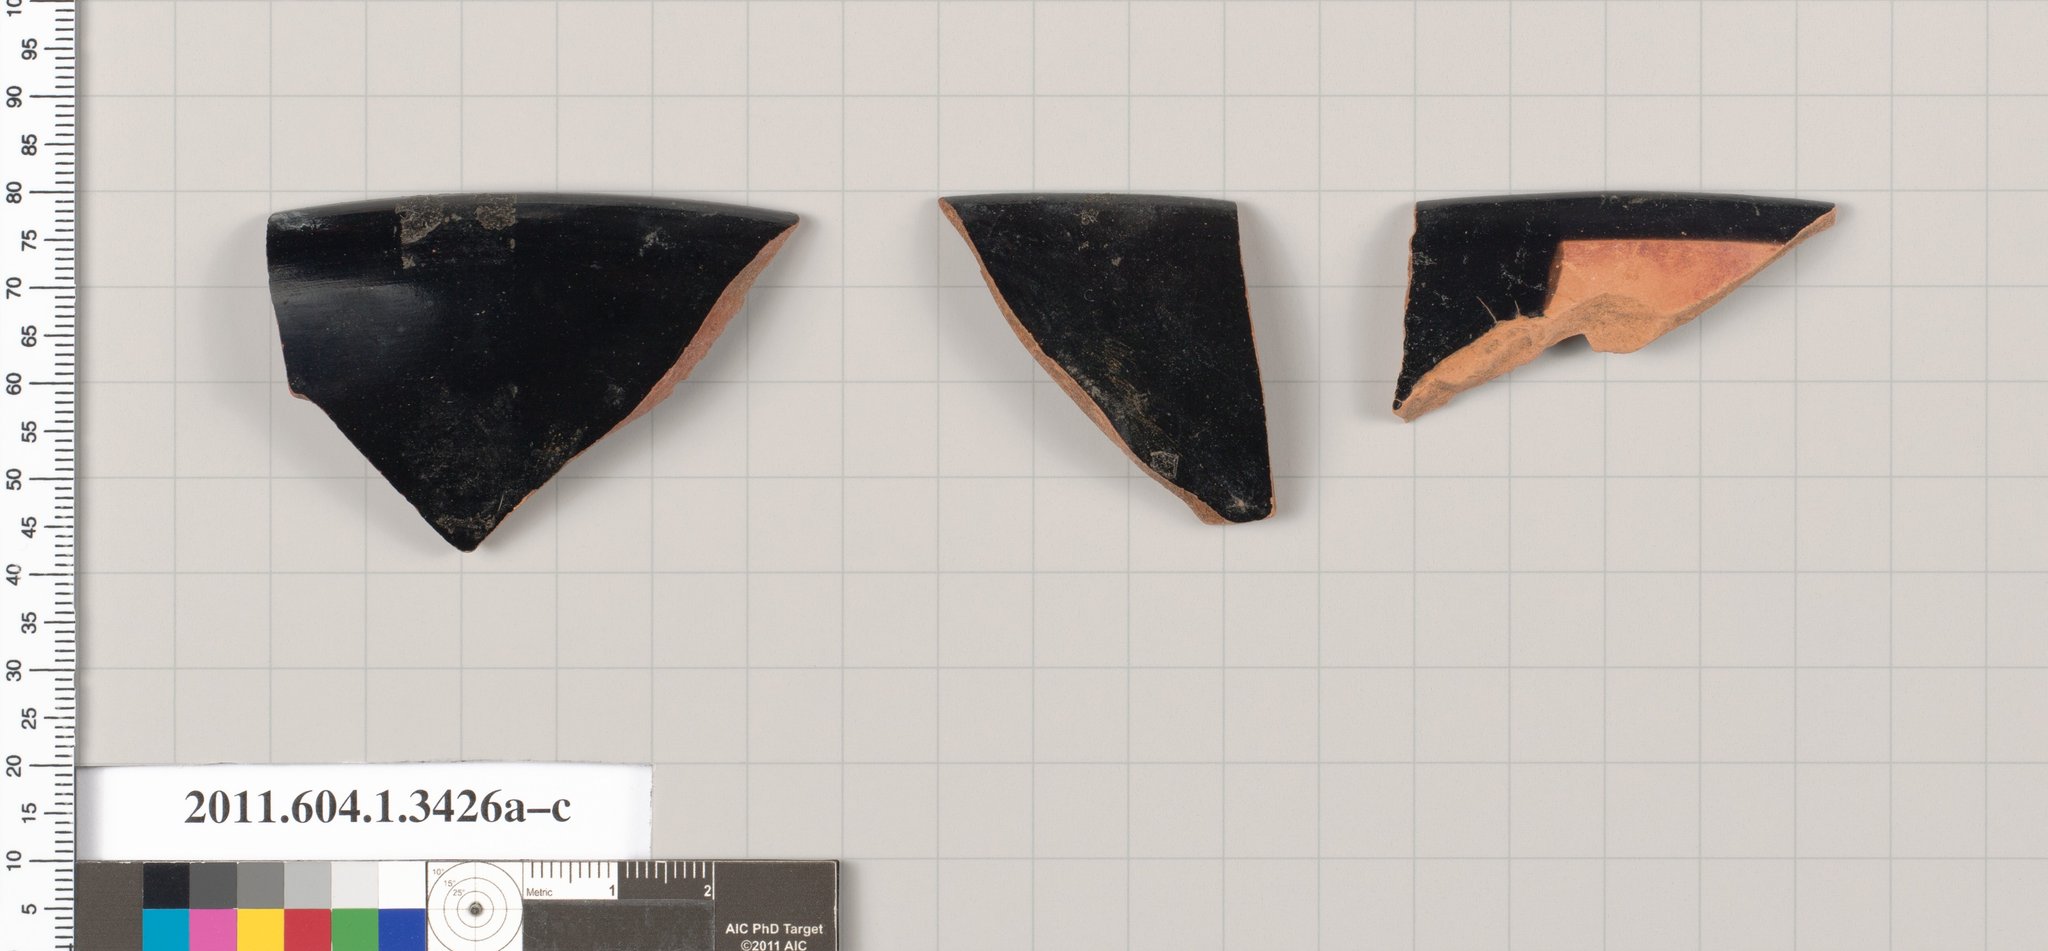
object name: kylix fragment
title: Terracotta fragments of kylikes (drinking cups)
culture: greek, attic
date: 500-470 BCE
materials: terracotta